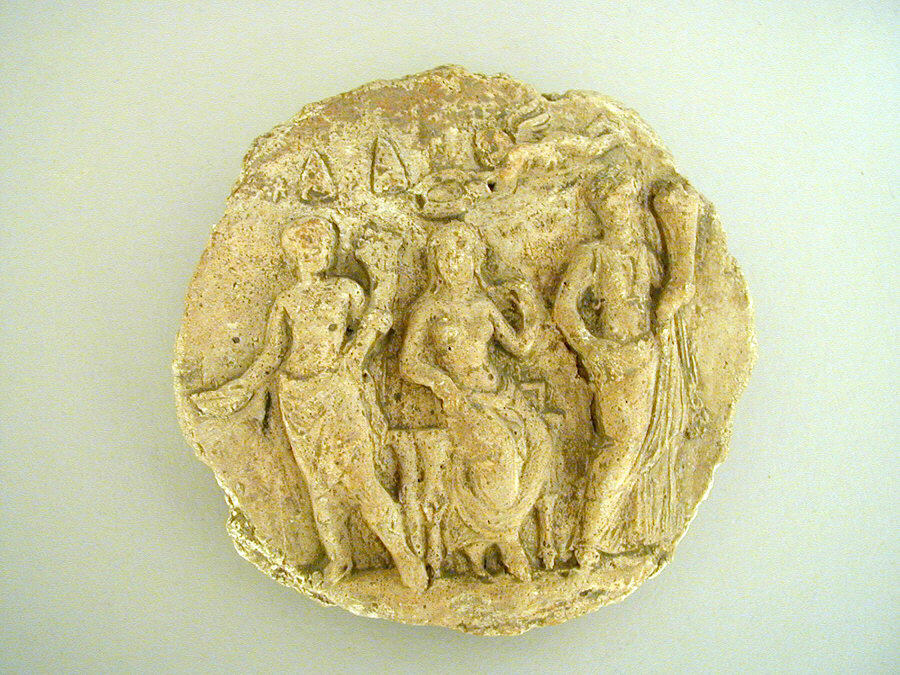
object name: mold of ancient cast for metal relief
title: Circular plaster relief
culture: roman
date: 1-100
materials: plaster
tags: women,eros,cornucopia